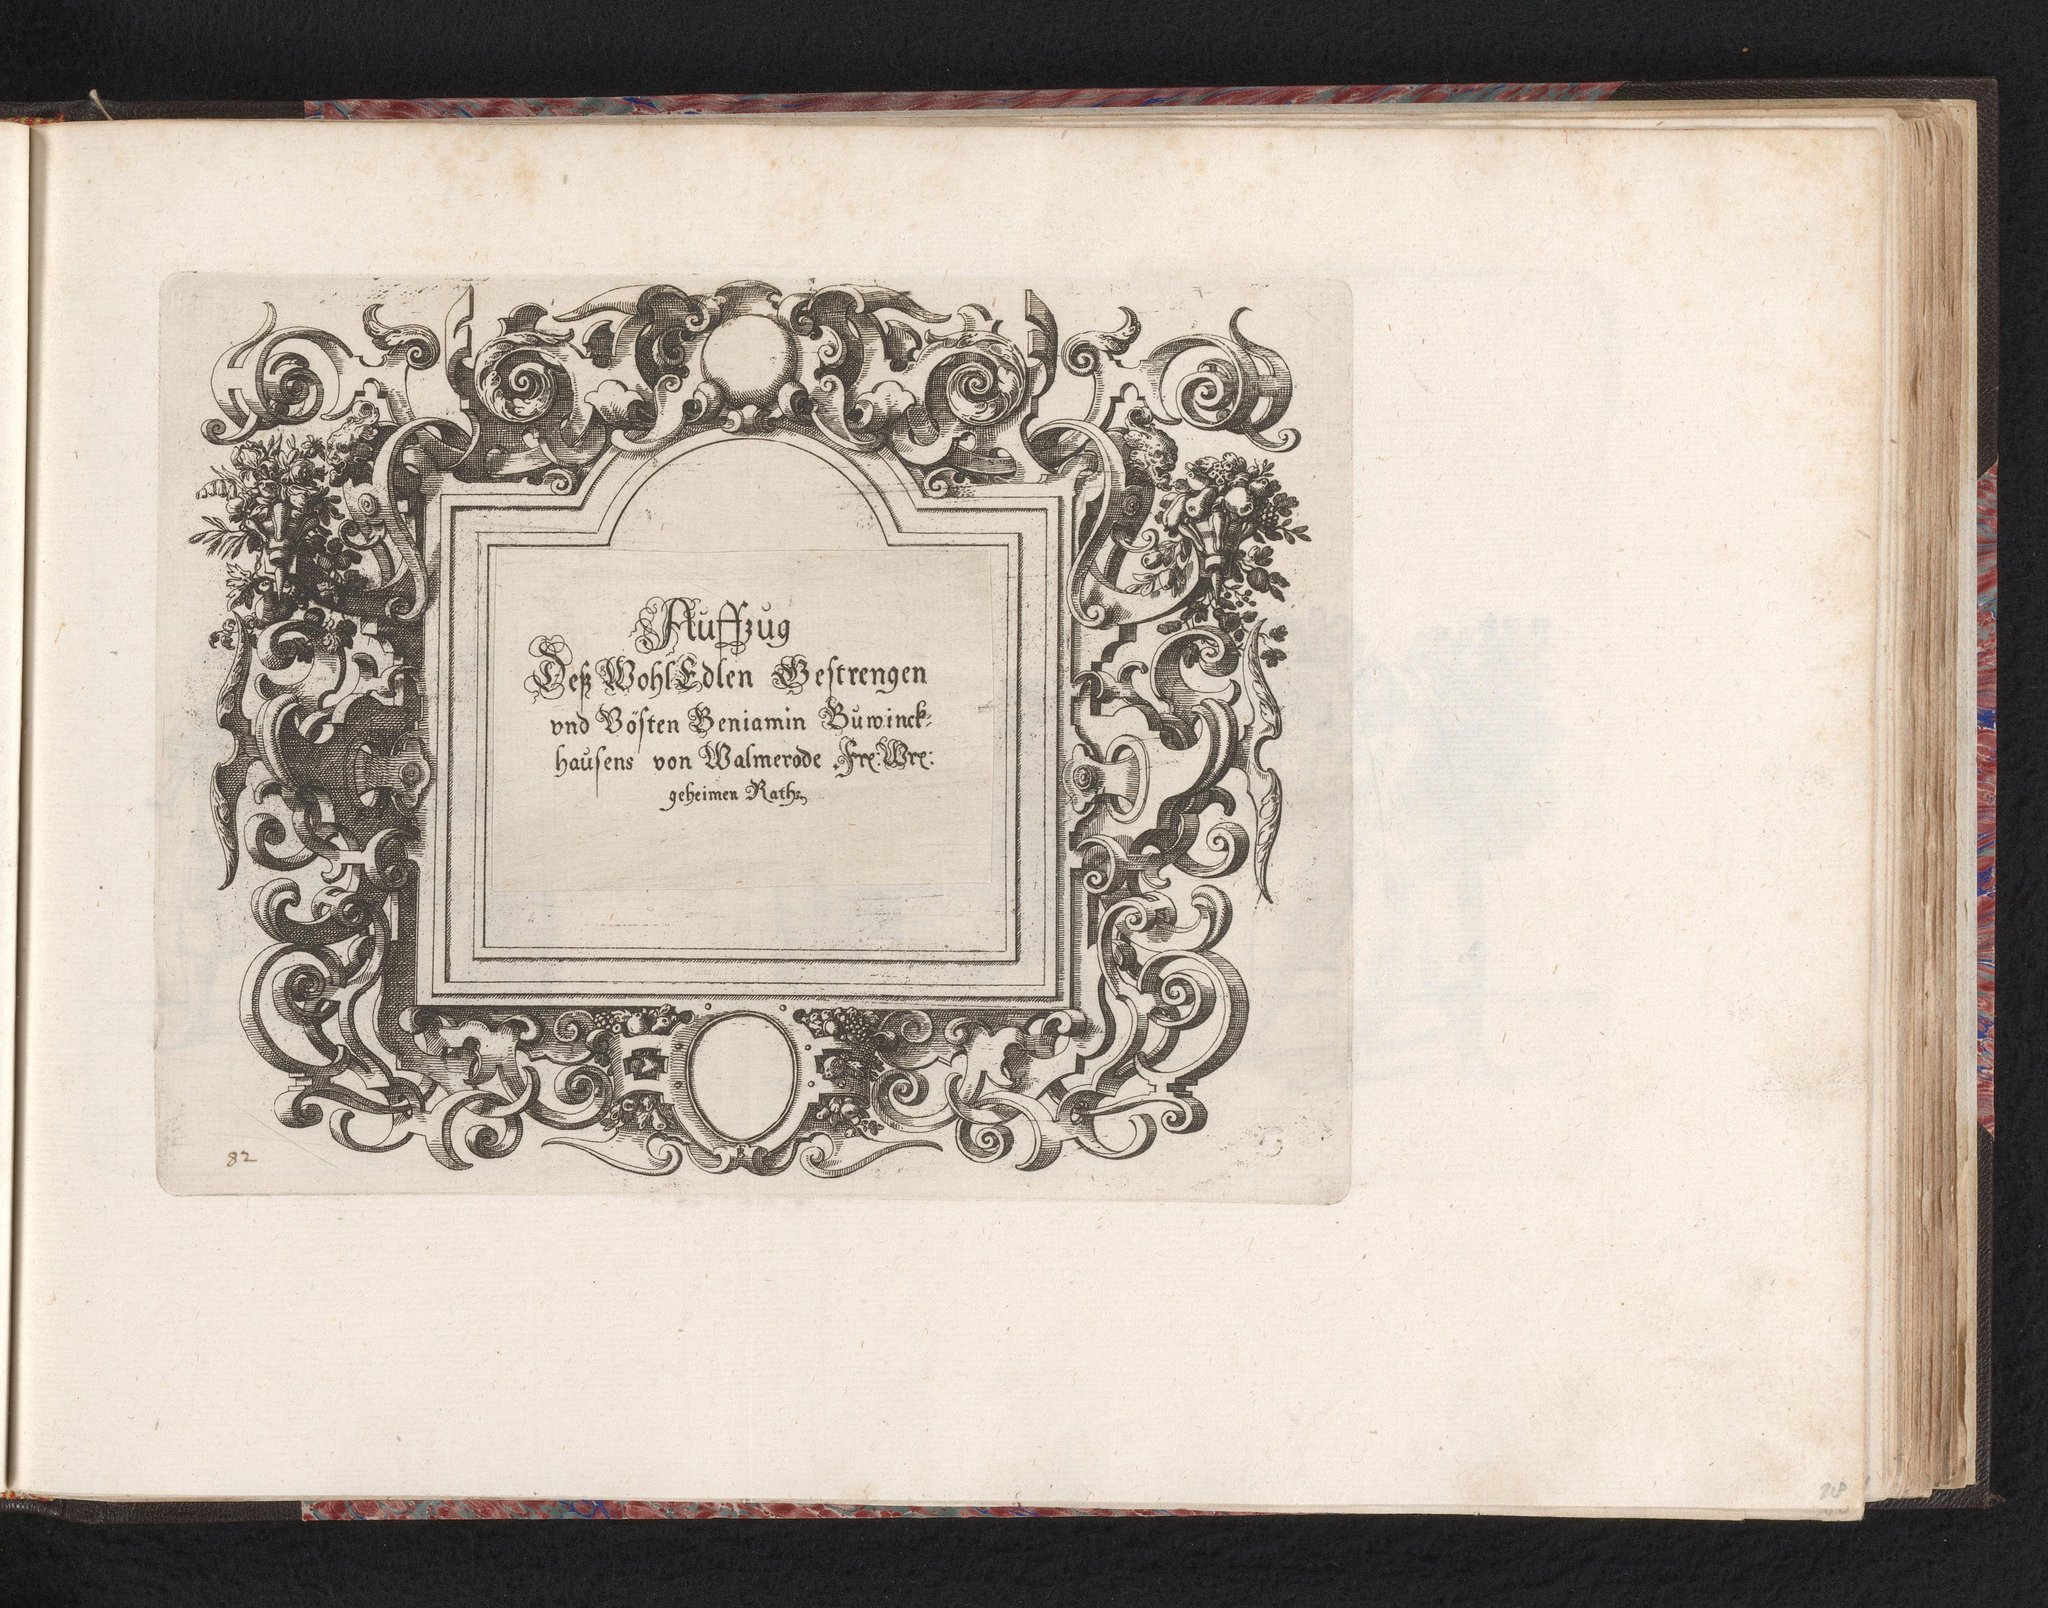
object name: album leaf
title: Band- en rolwerk met saters om een cartouche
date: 1618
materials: paper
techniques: etching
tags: politician, benjamin von bouwinghausen von walmerode, performance in the open air (pleasure fair), flowers ~ ornament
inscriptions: annotation: ‘82’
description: Met tekst in het Duits in de cartouche. Deze prent maakt deel uit van een album.